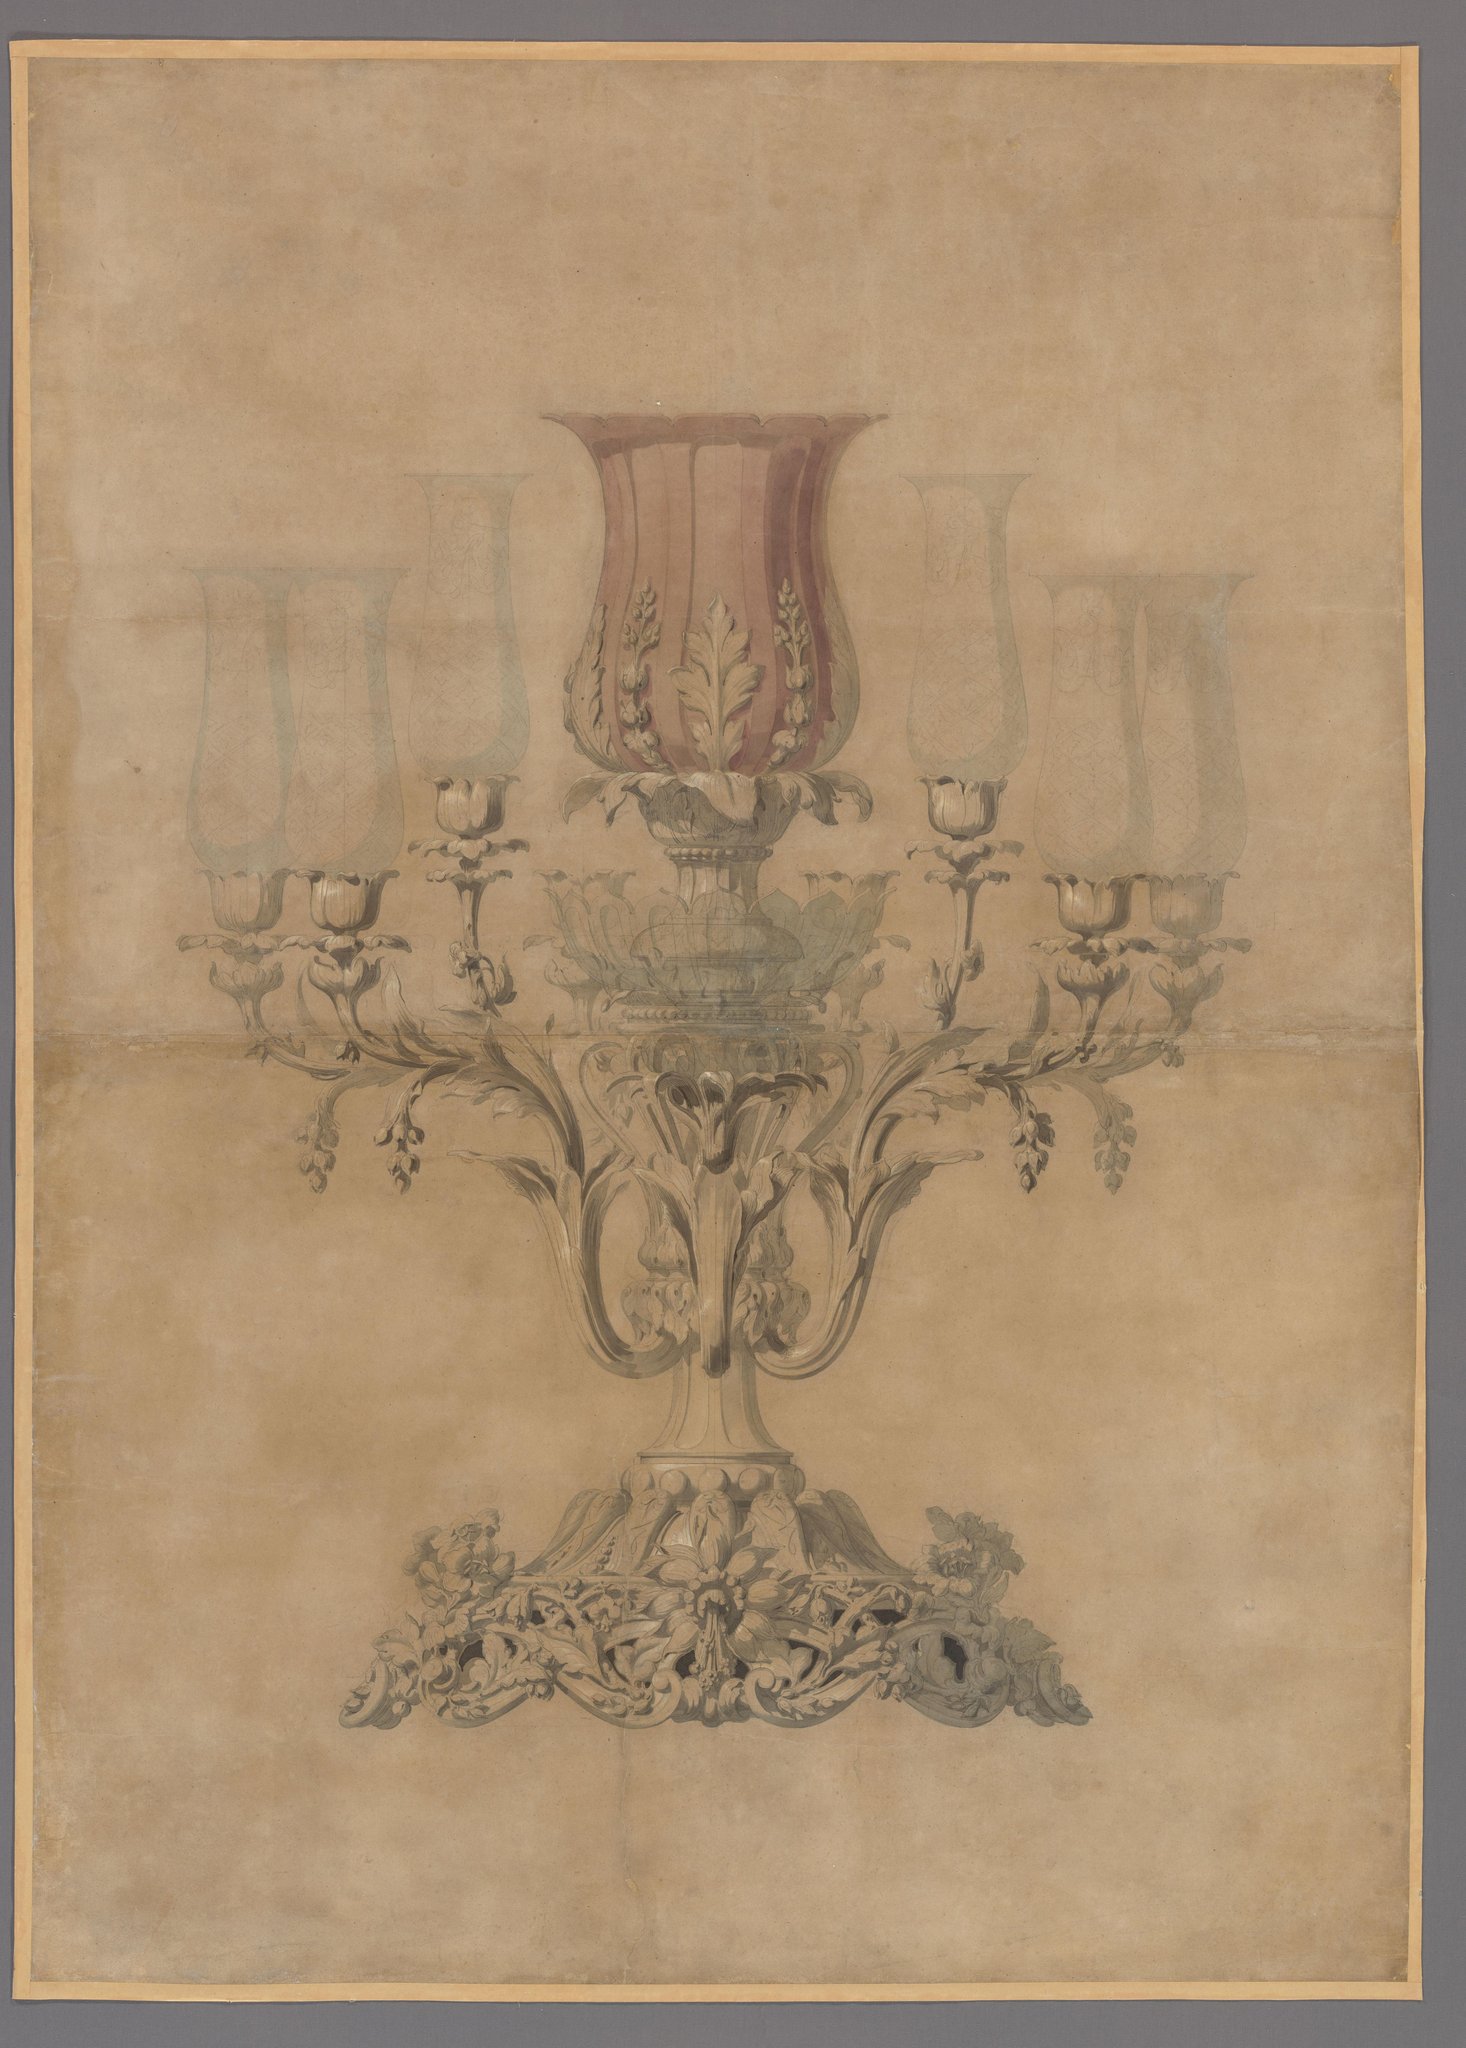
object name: drawing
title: Ontwerp voor een kandelaber met glazen coupes en kappen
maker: charles nicolas odiot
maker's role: jeweler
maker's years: 1789-1869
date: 1850-1860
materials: paint, graphite, ink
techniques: brush, pen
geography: paris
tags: chandelier, candelabrum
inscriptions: coat of arms